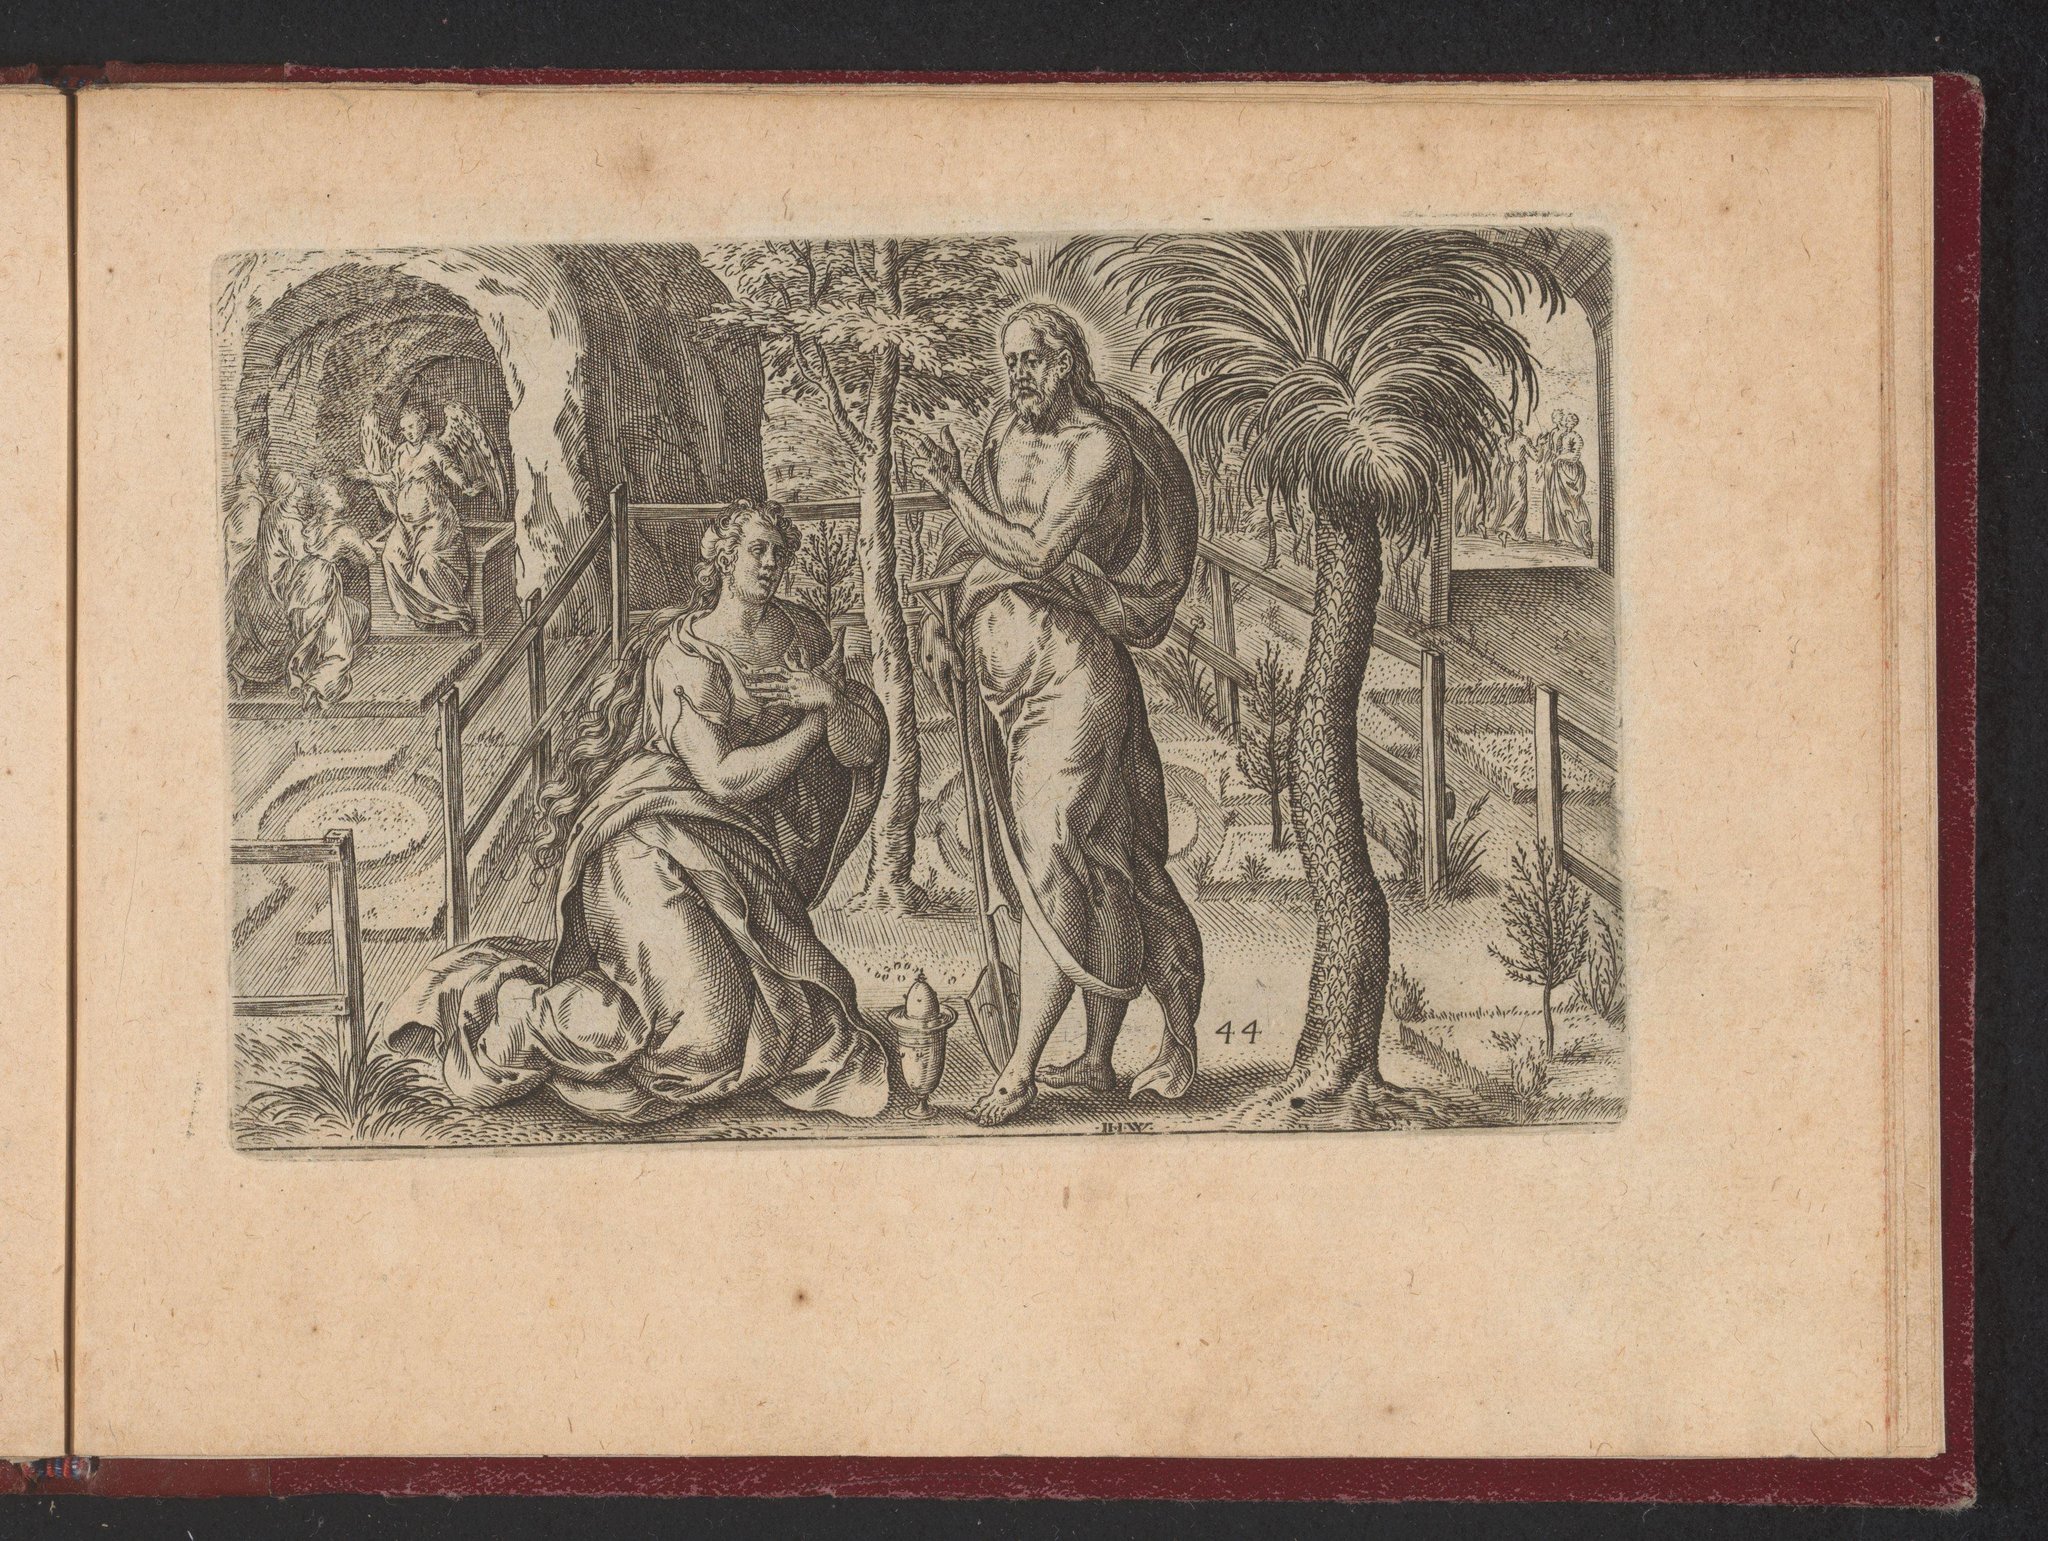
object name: print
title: Christi Iesu vitae admirabiliumque actionum speculum a Philippo Gallaeo apparatum Bened. Ariae Montani singuloribus distichis instructum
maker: johannes wierix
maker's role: draughtsman, print maker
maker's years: 1549-1618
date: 1573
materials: paper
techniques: engraving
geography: antwerp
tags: mary magdalene kneeling before christ, who is usually represented as a gardener with a hoe and/or a spade; 'noli me tangere'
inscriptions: watermark: ‘gotische letter P’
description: Onderdeel van een album met een titelprent en een serie van 50 prenten betreffende het leven en de passie van Christus.